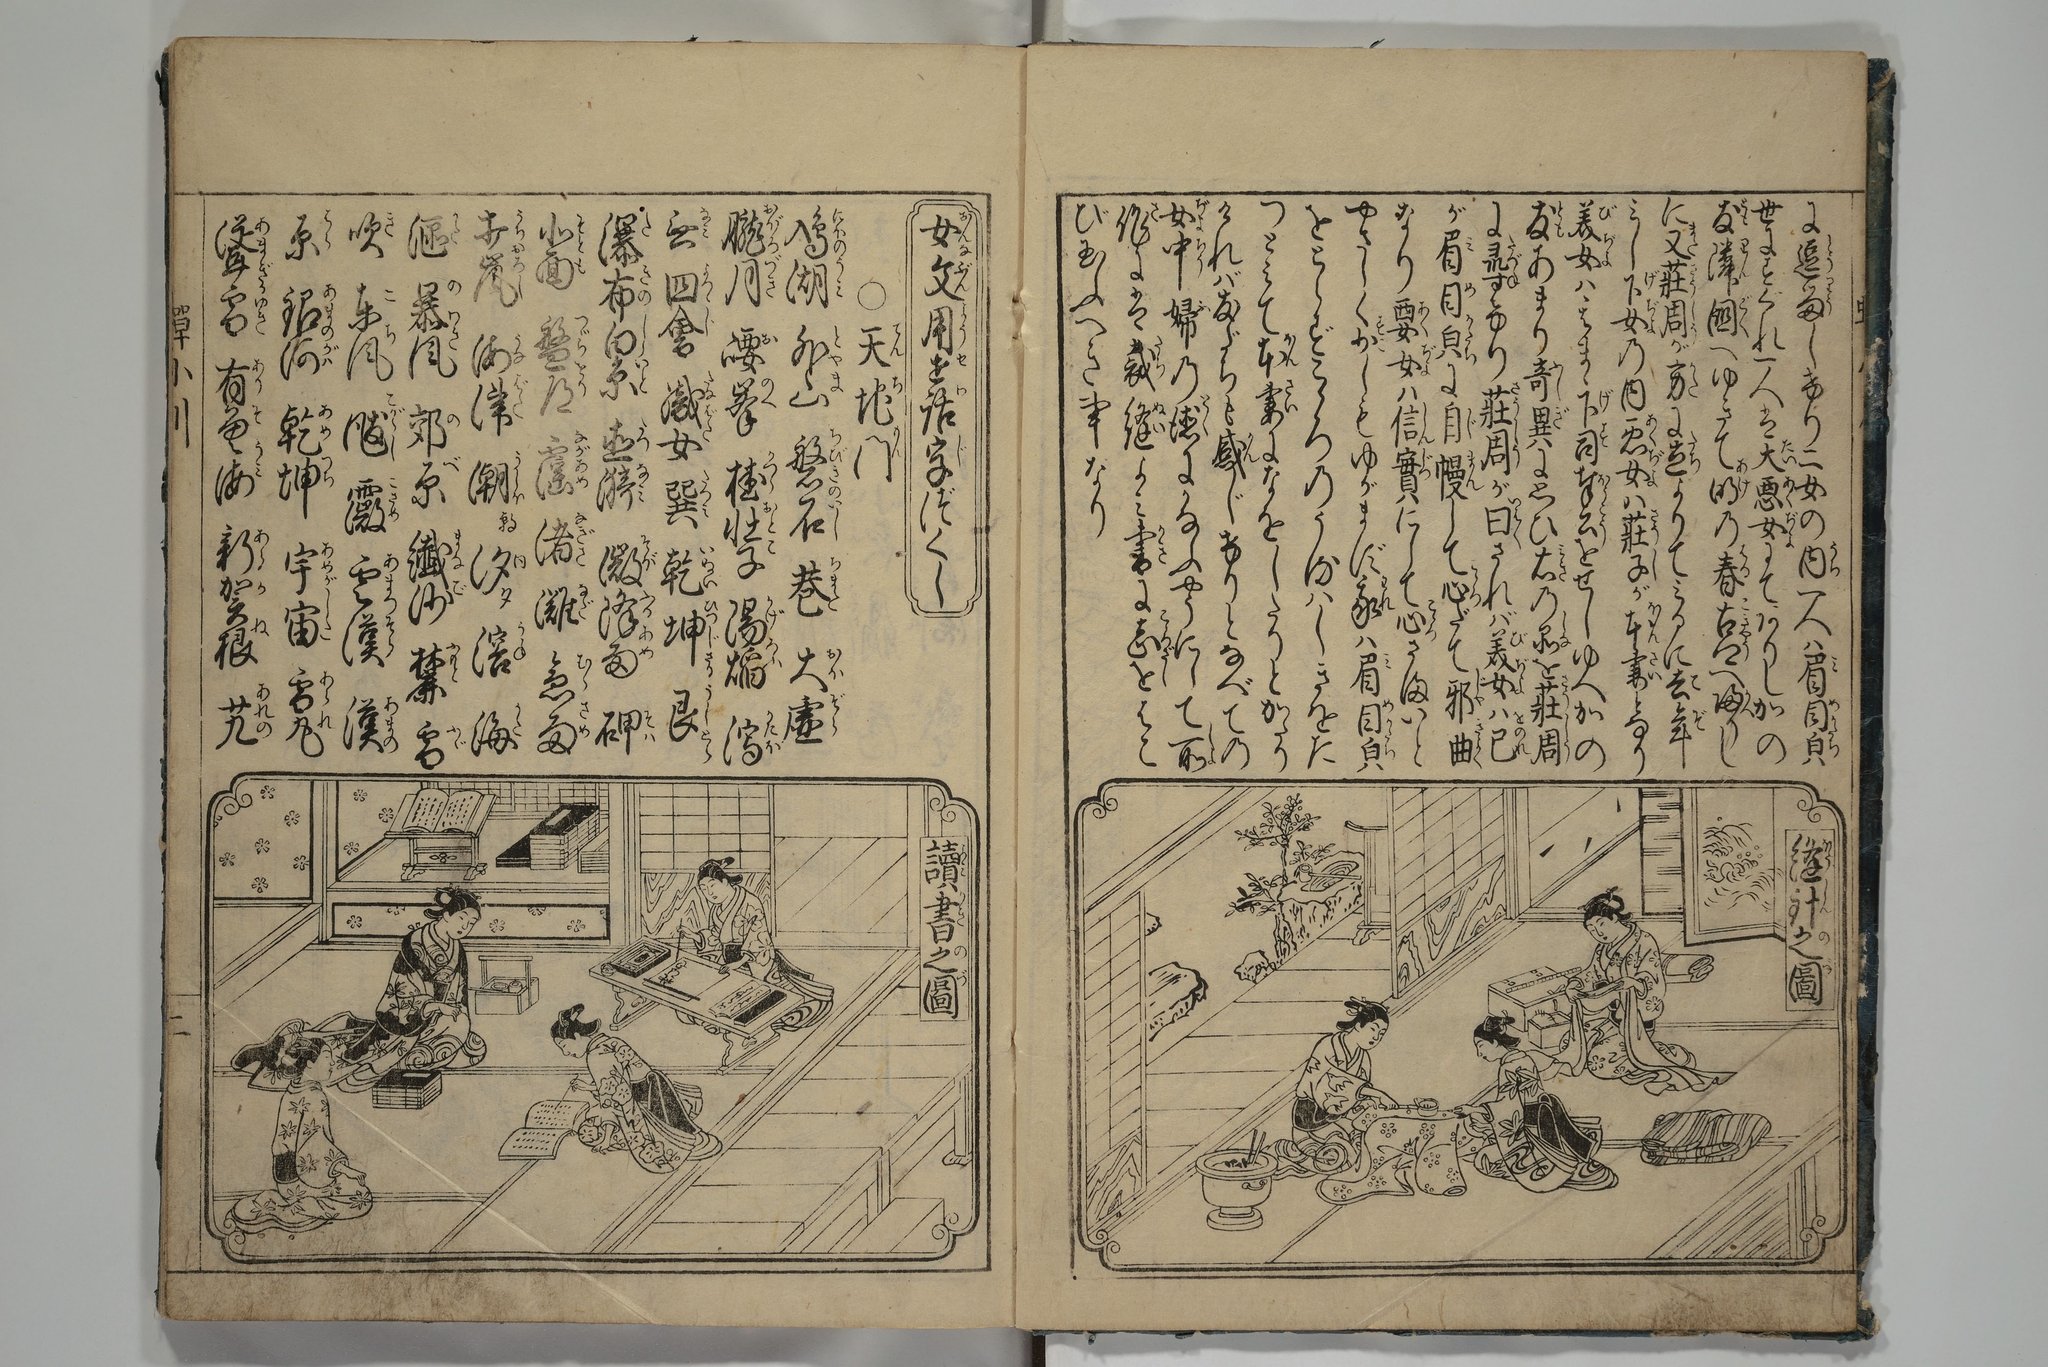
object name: illustrated book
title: The Cicada Stream (Semi no Ogawa) 蝉小川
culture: japanese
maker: hasegawa myōtei 長谷川妙躰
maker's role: calligrapher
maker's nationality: japanese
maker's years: 1667-1699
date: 1838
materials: ink, paper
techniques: woodblock print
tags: women,working,writing,calligraphy